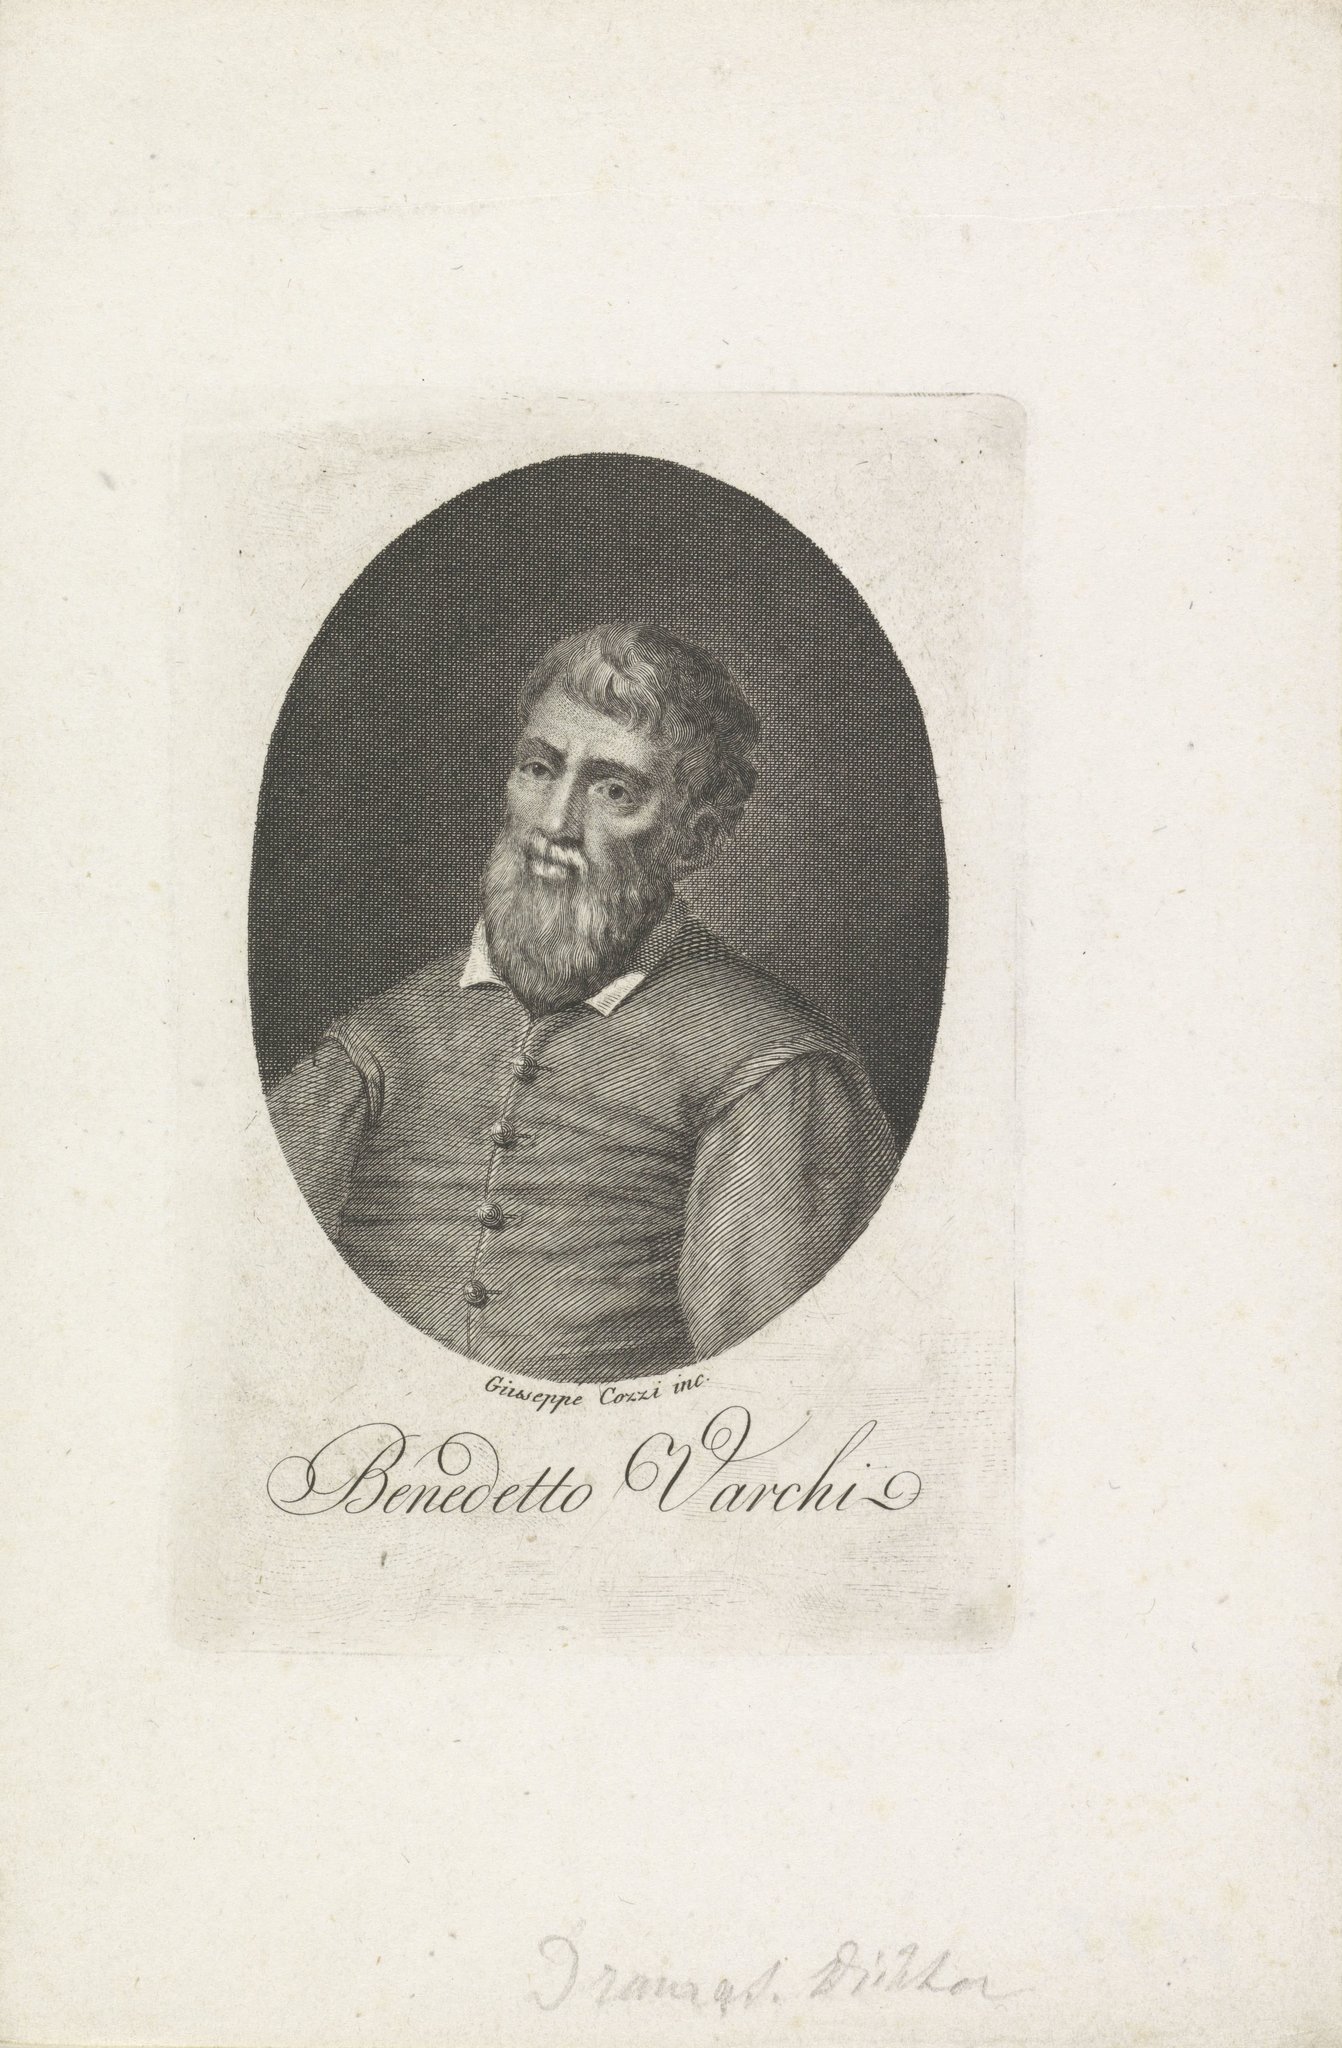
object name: print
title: Portret van Benedetto Varchi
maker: giuseppe cozzi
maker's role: print maker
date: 1827-1837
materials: paper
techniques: engraving, etching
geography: italy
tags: draughtsman, historical persons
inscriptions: collector's mark: Lugt 2228